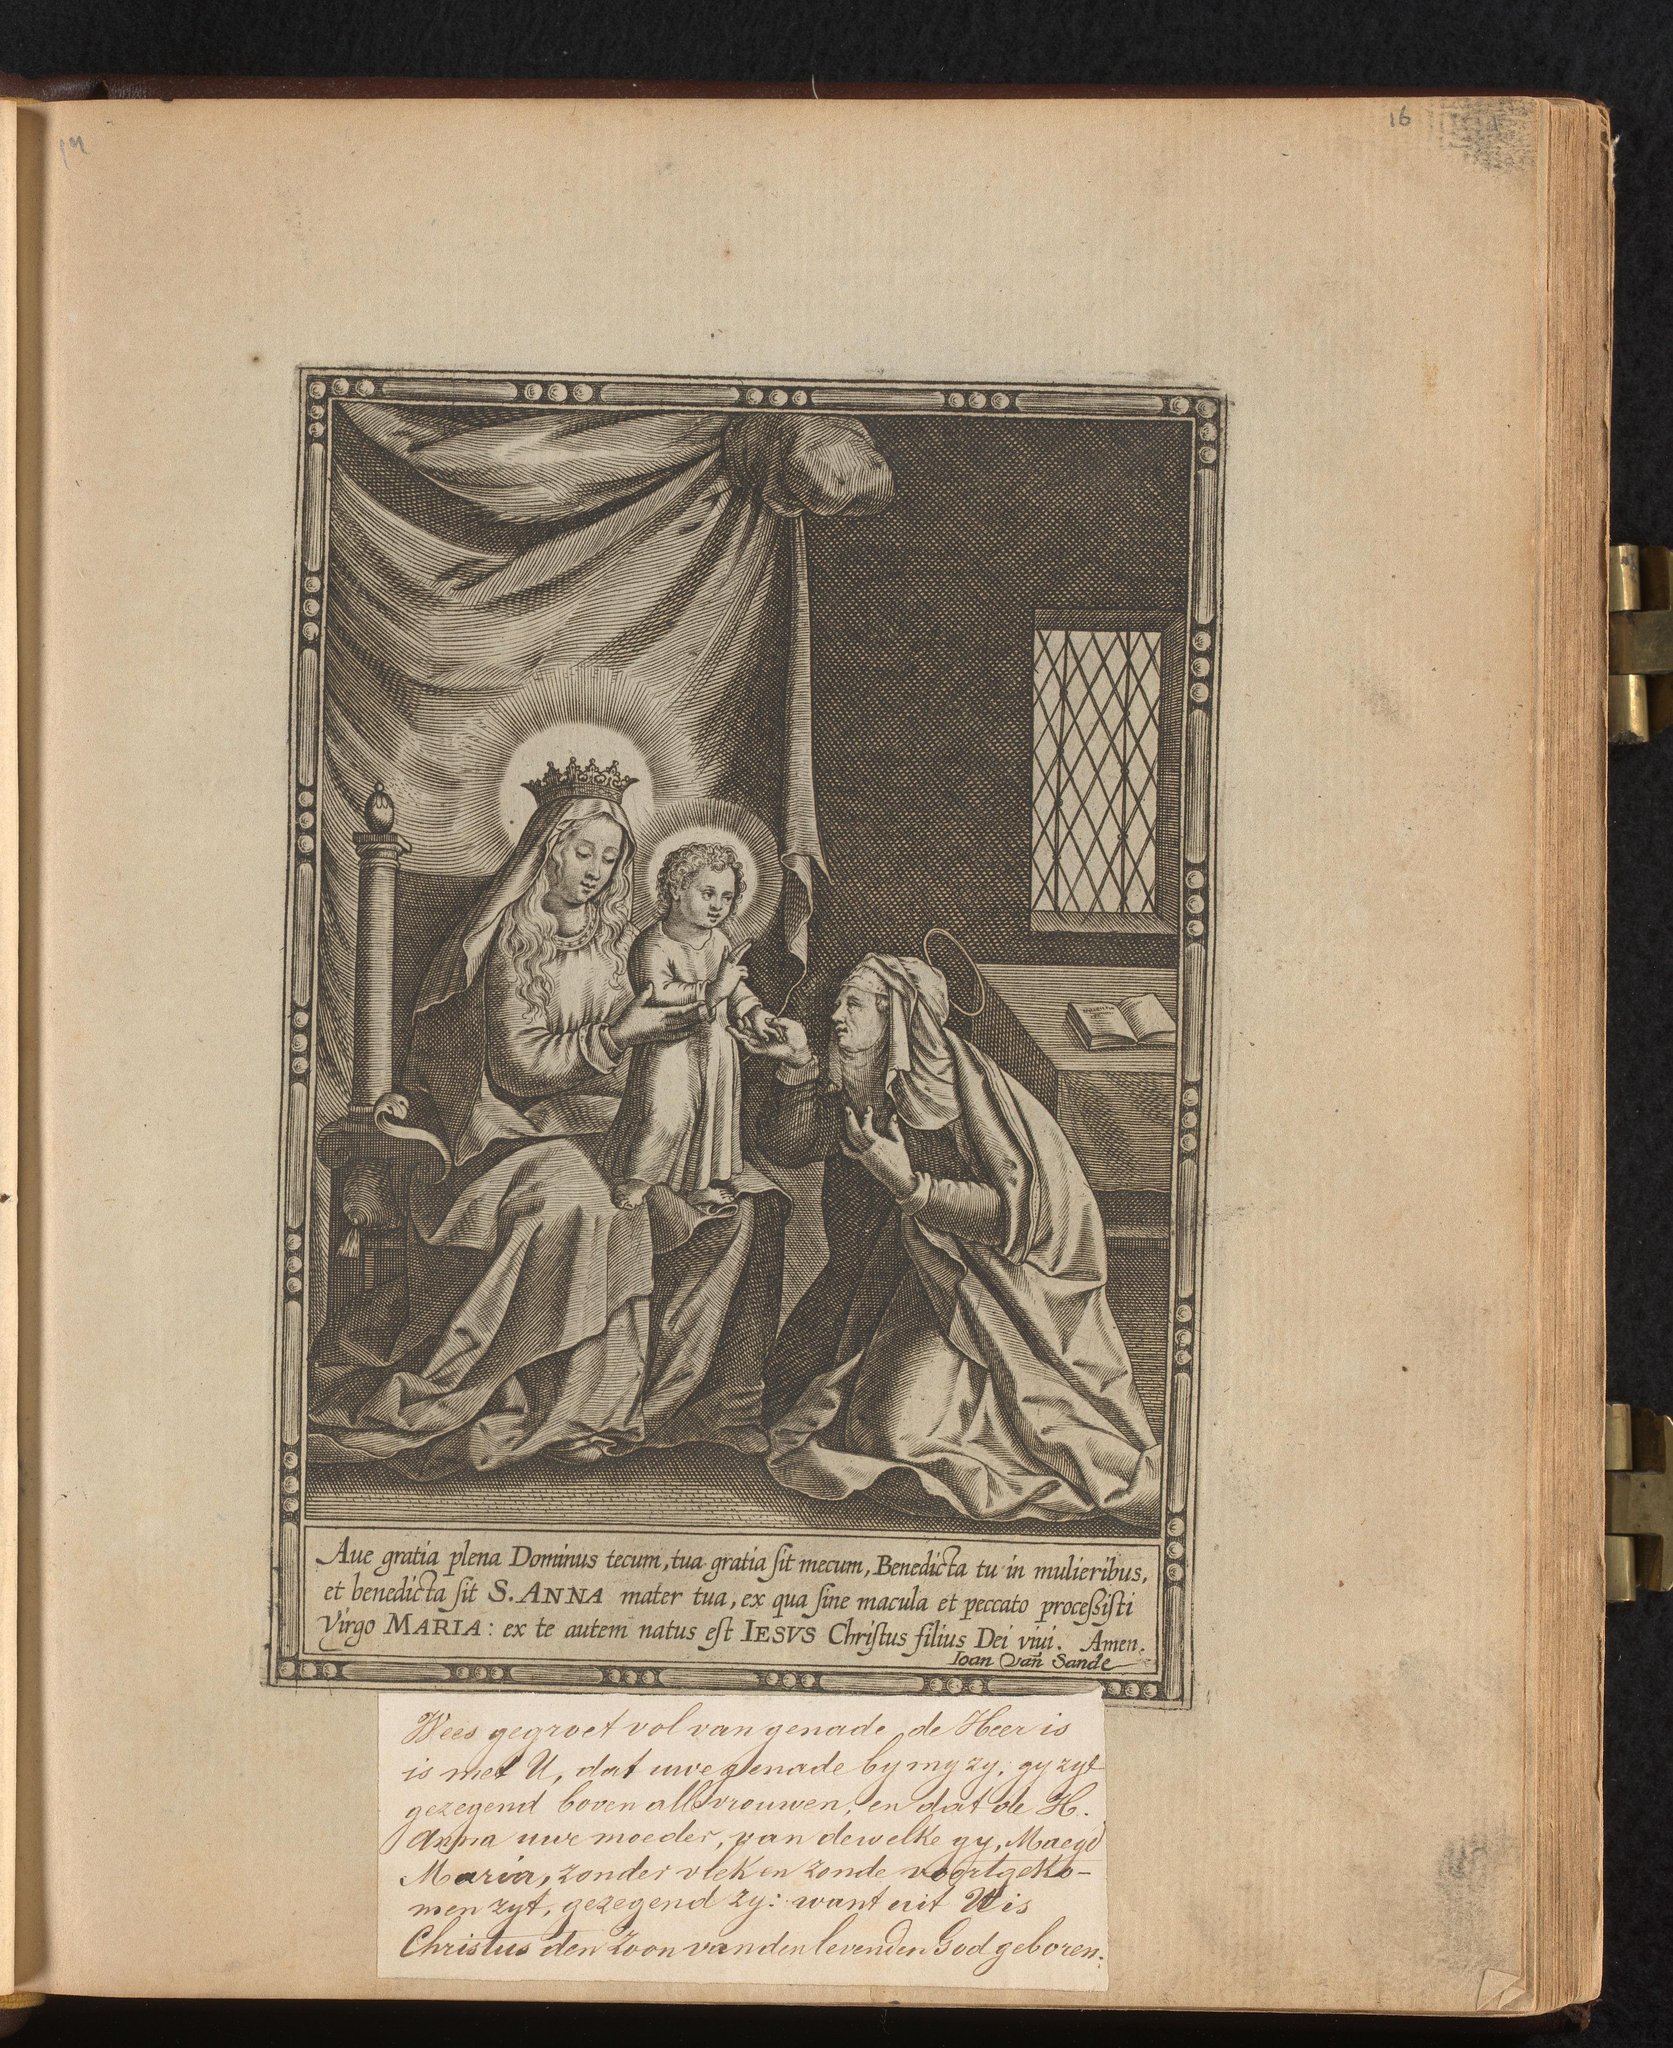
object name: print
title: Anna te drieën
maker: jan van de sande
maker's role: painter, print maker, publisher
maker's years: 1600-1665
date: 1610-1665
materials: paper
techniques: engraving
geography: antwerp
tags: 'anna selbdritt', i.e. anna, mary and christ-child close together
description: Prent in: s.n. Aldernouwkeurigste verhandelinge der geschiedenissen van het Nieuw Testament (...). Antwerpen: Cornelis Marten Spanoghe, 1783, p. 18-19..